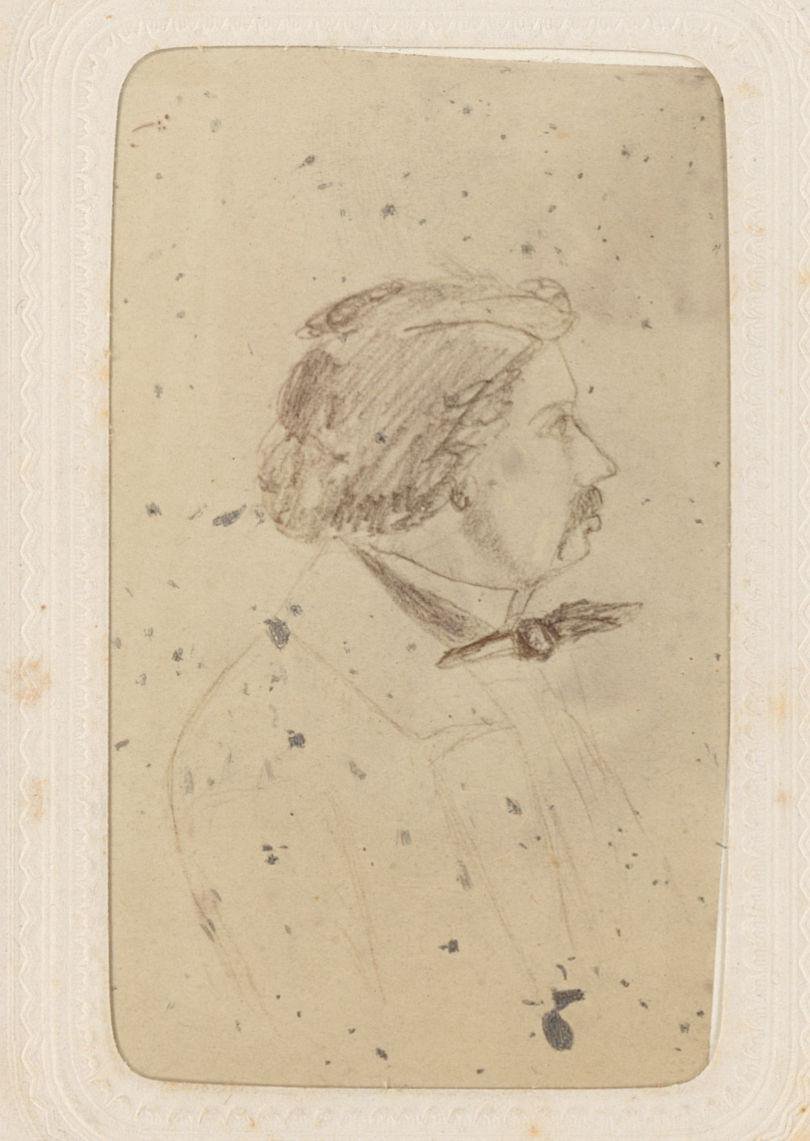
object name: carte de visite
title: Getekend portret van een man met een snor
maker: henri pronk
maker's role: fotograaf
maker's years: 1813-1893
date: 1863-1866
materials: cardboard, paper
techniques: albumen print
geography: utrecht